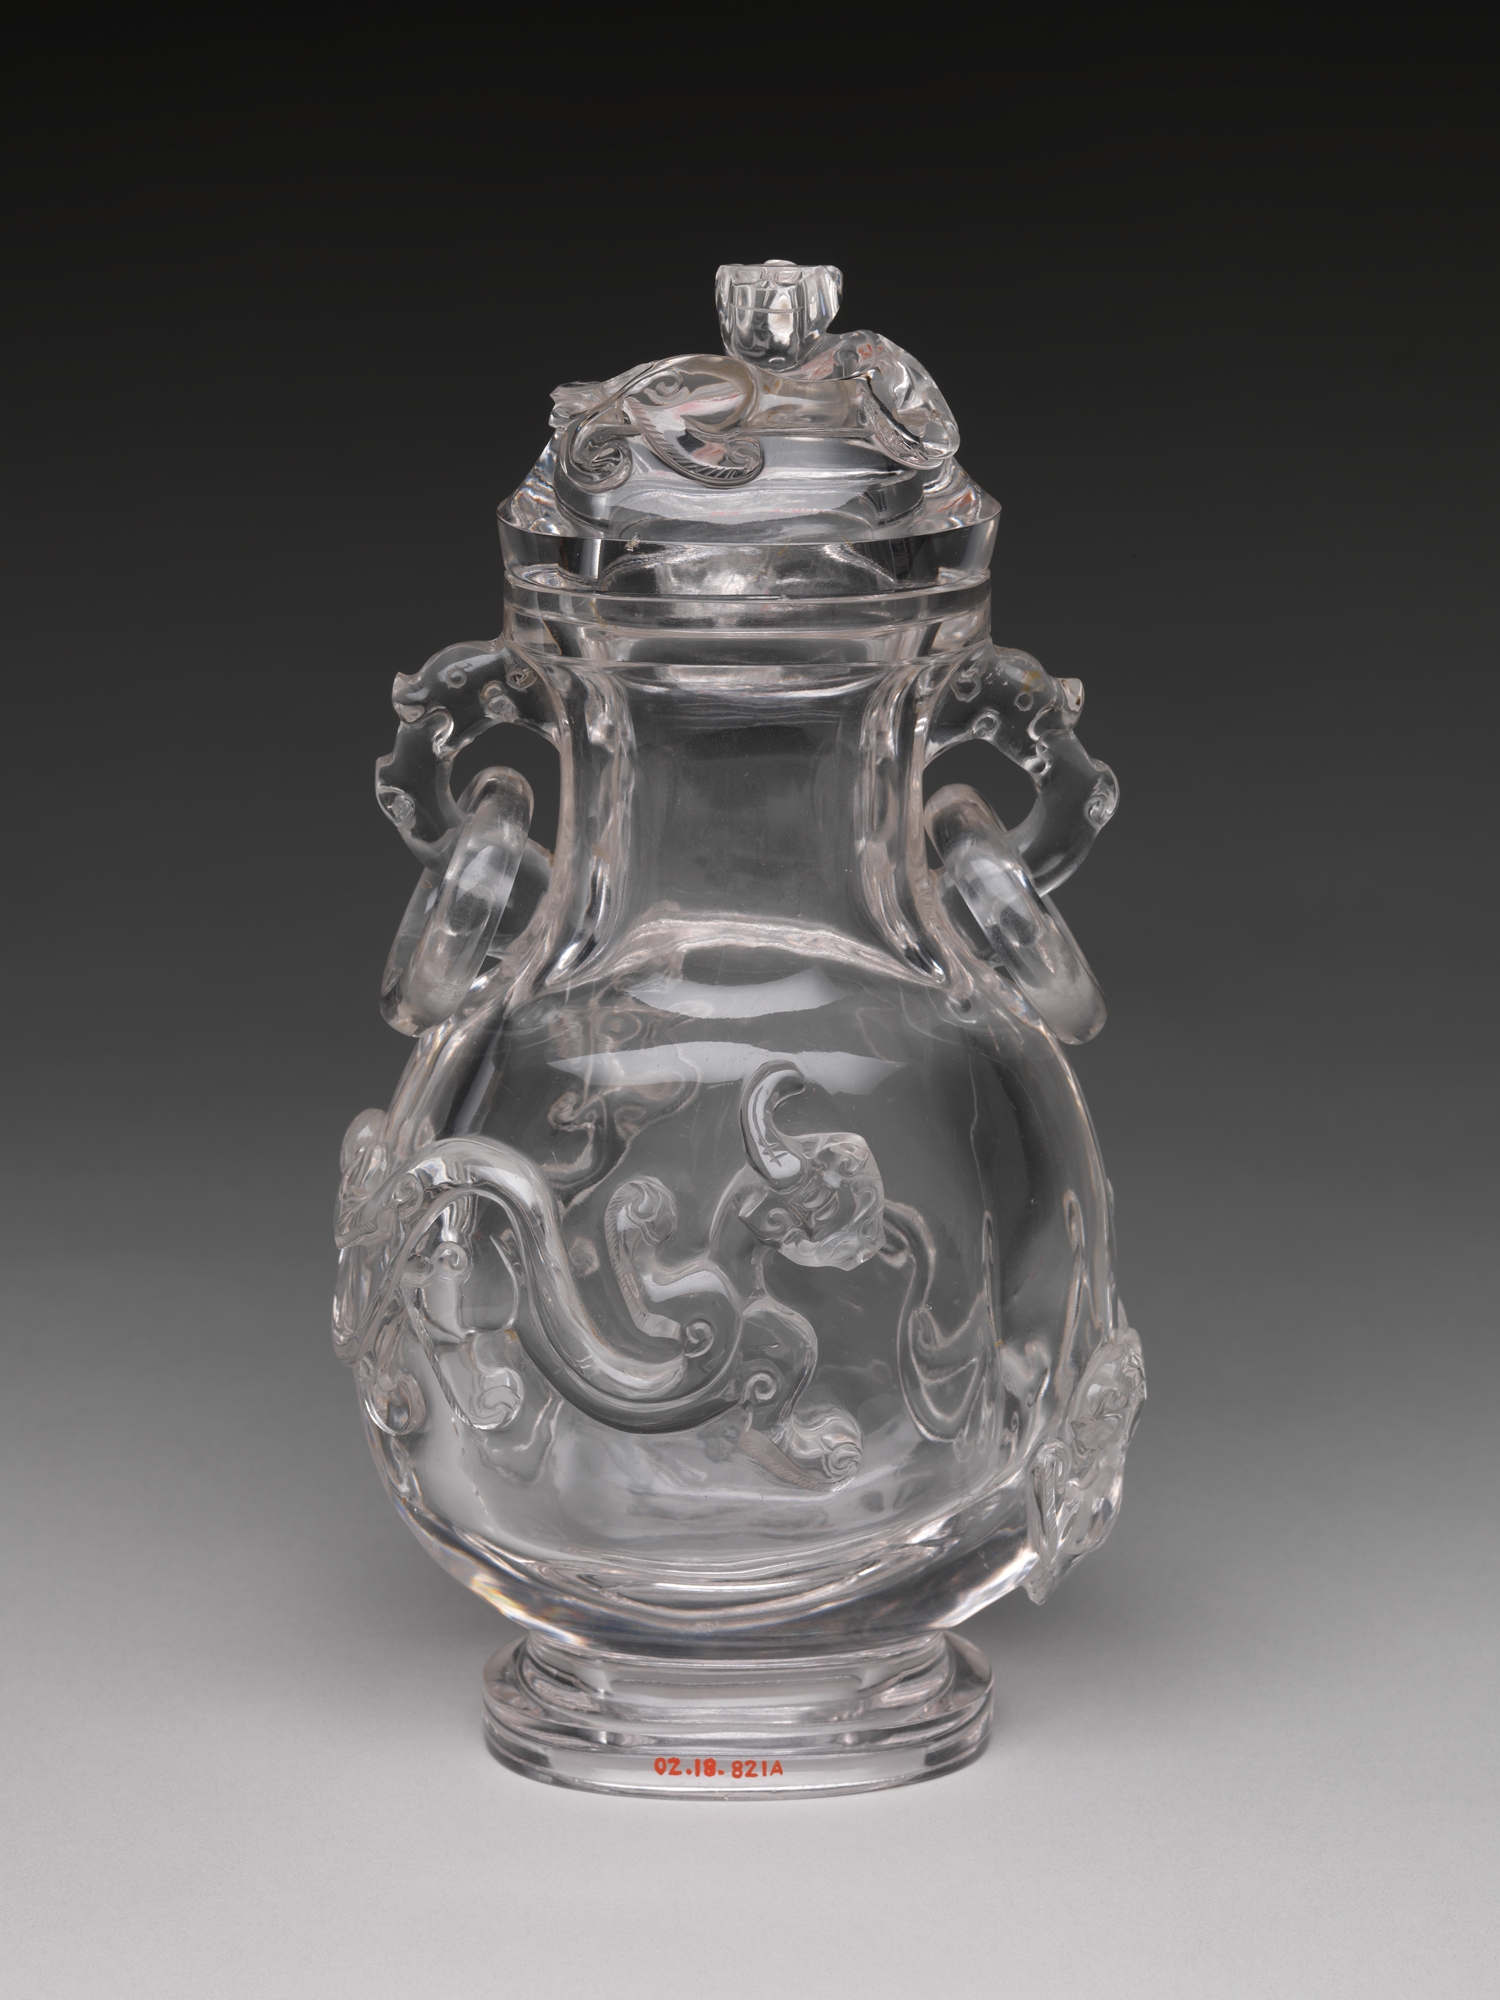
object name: vase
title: Vase with Dragons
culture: chinese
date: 1701-1800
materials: quartz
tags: dragons